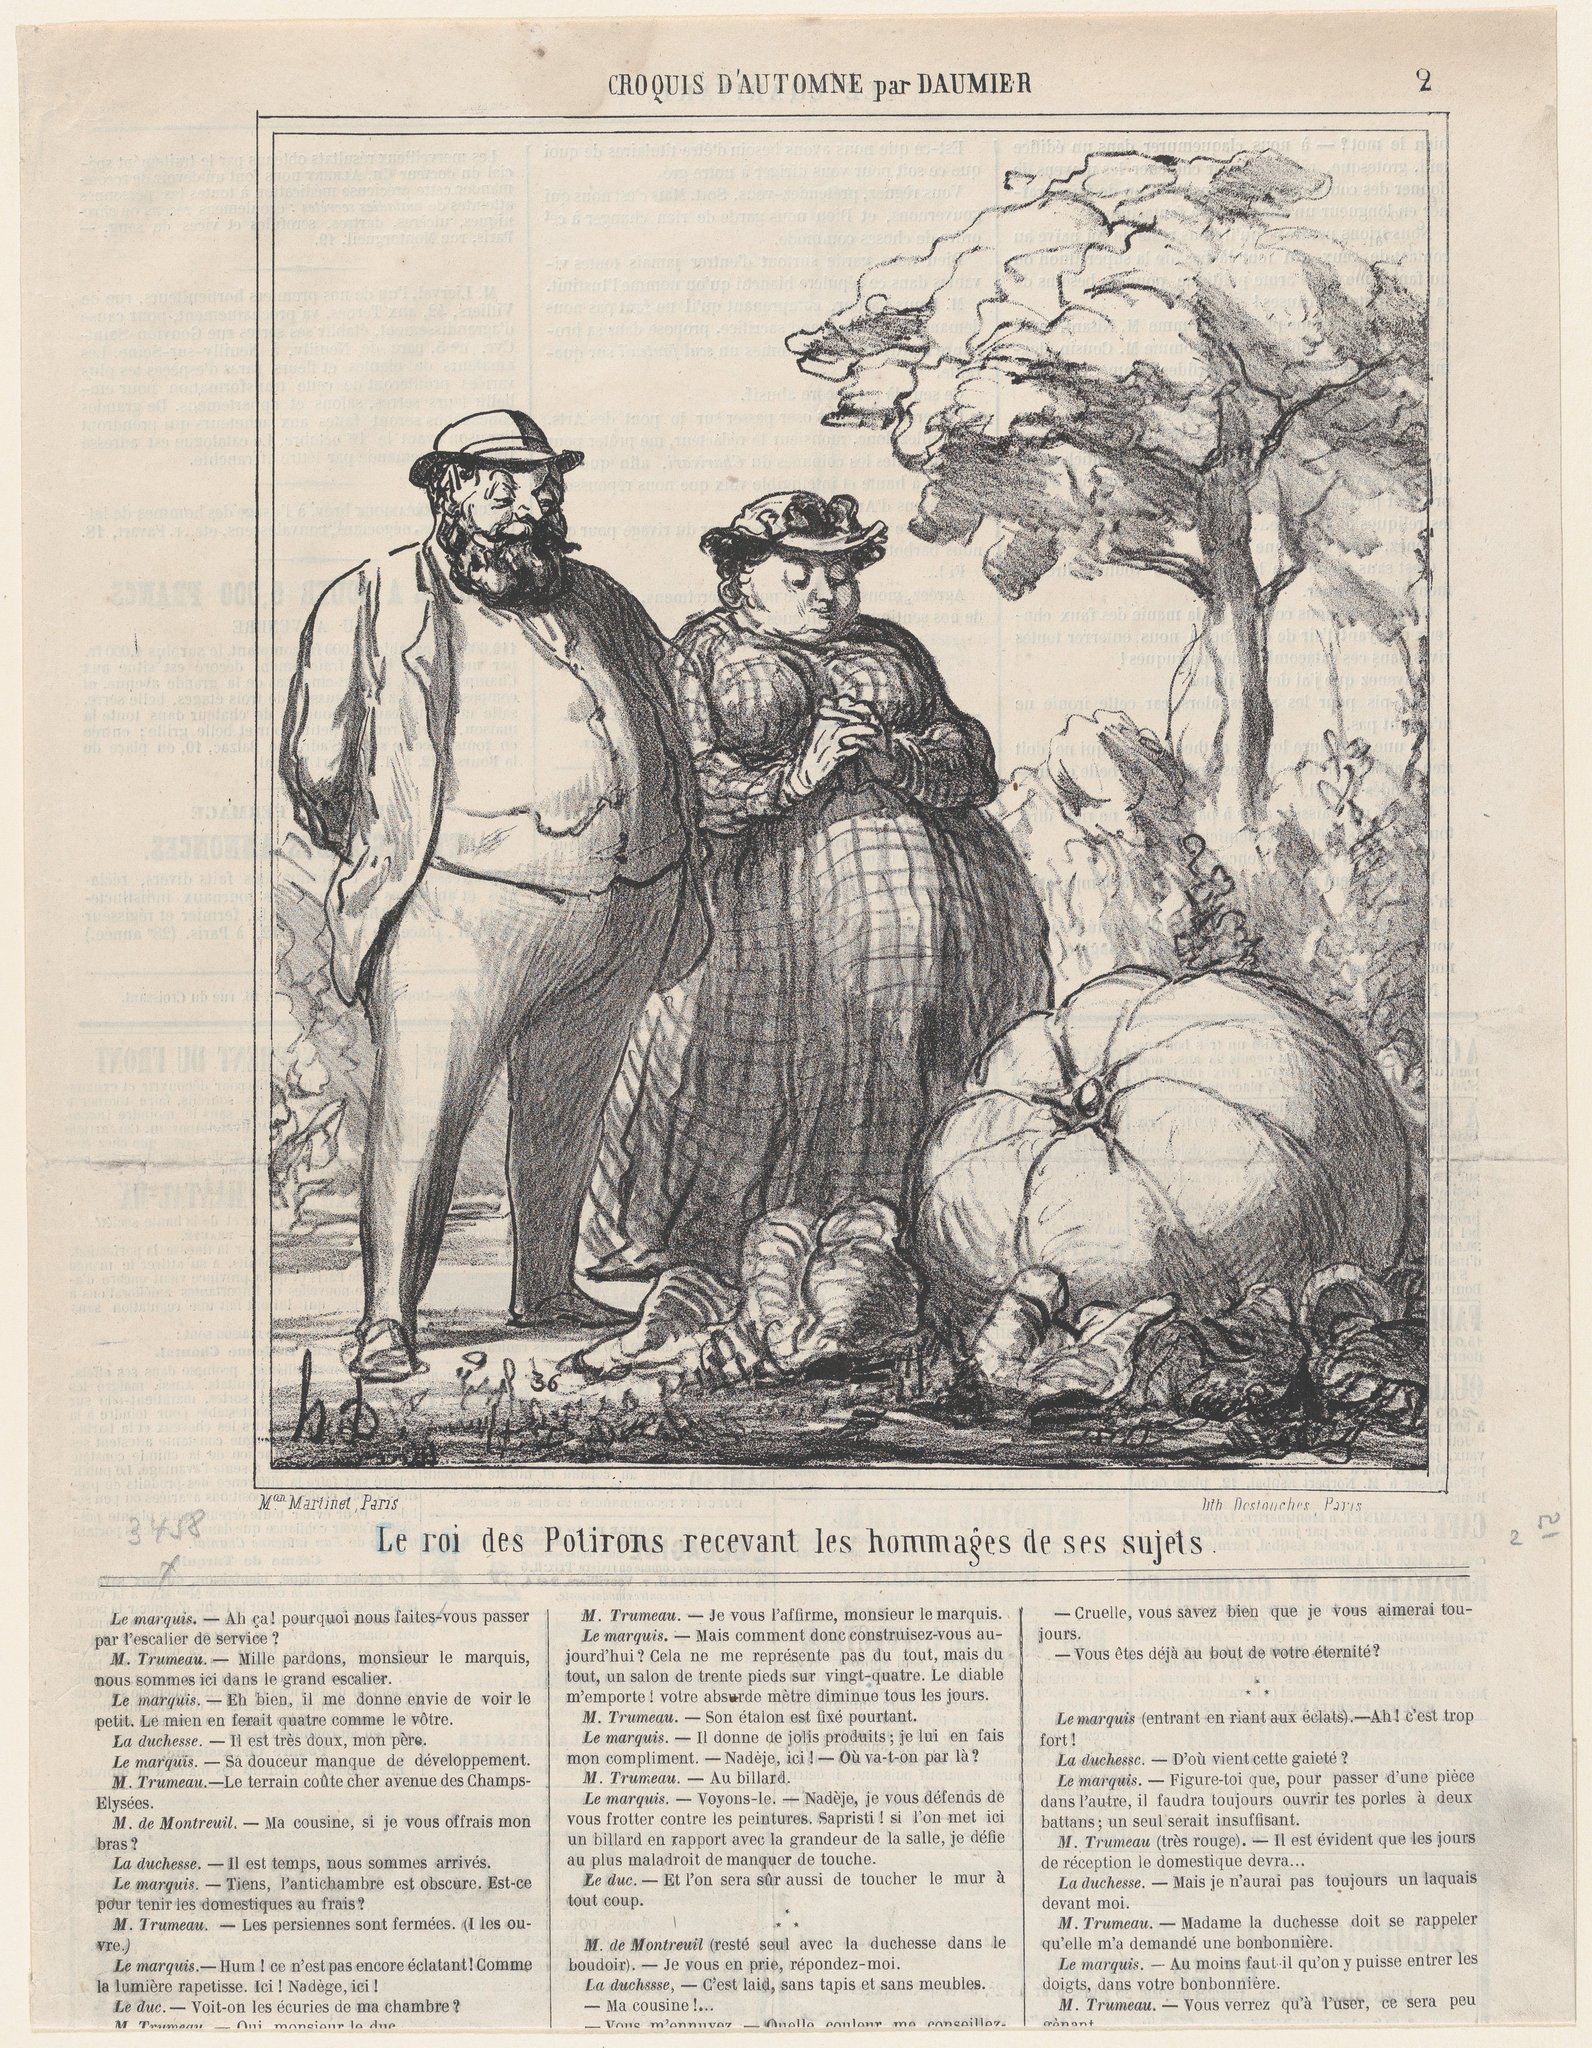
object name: print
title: The king of pumpkins receiving the homage of his subjects, from "Autumn sketches"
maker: honoré daumier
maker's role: artist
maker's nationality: french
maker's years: 1808-1879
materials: paper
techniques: lithograph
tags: vegetables,men,women